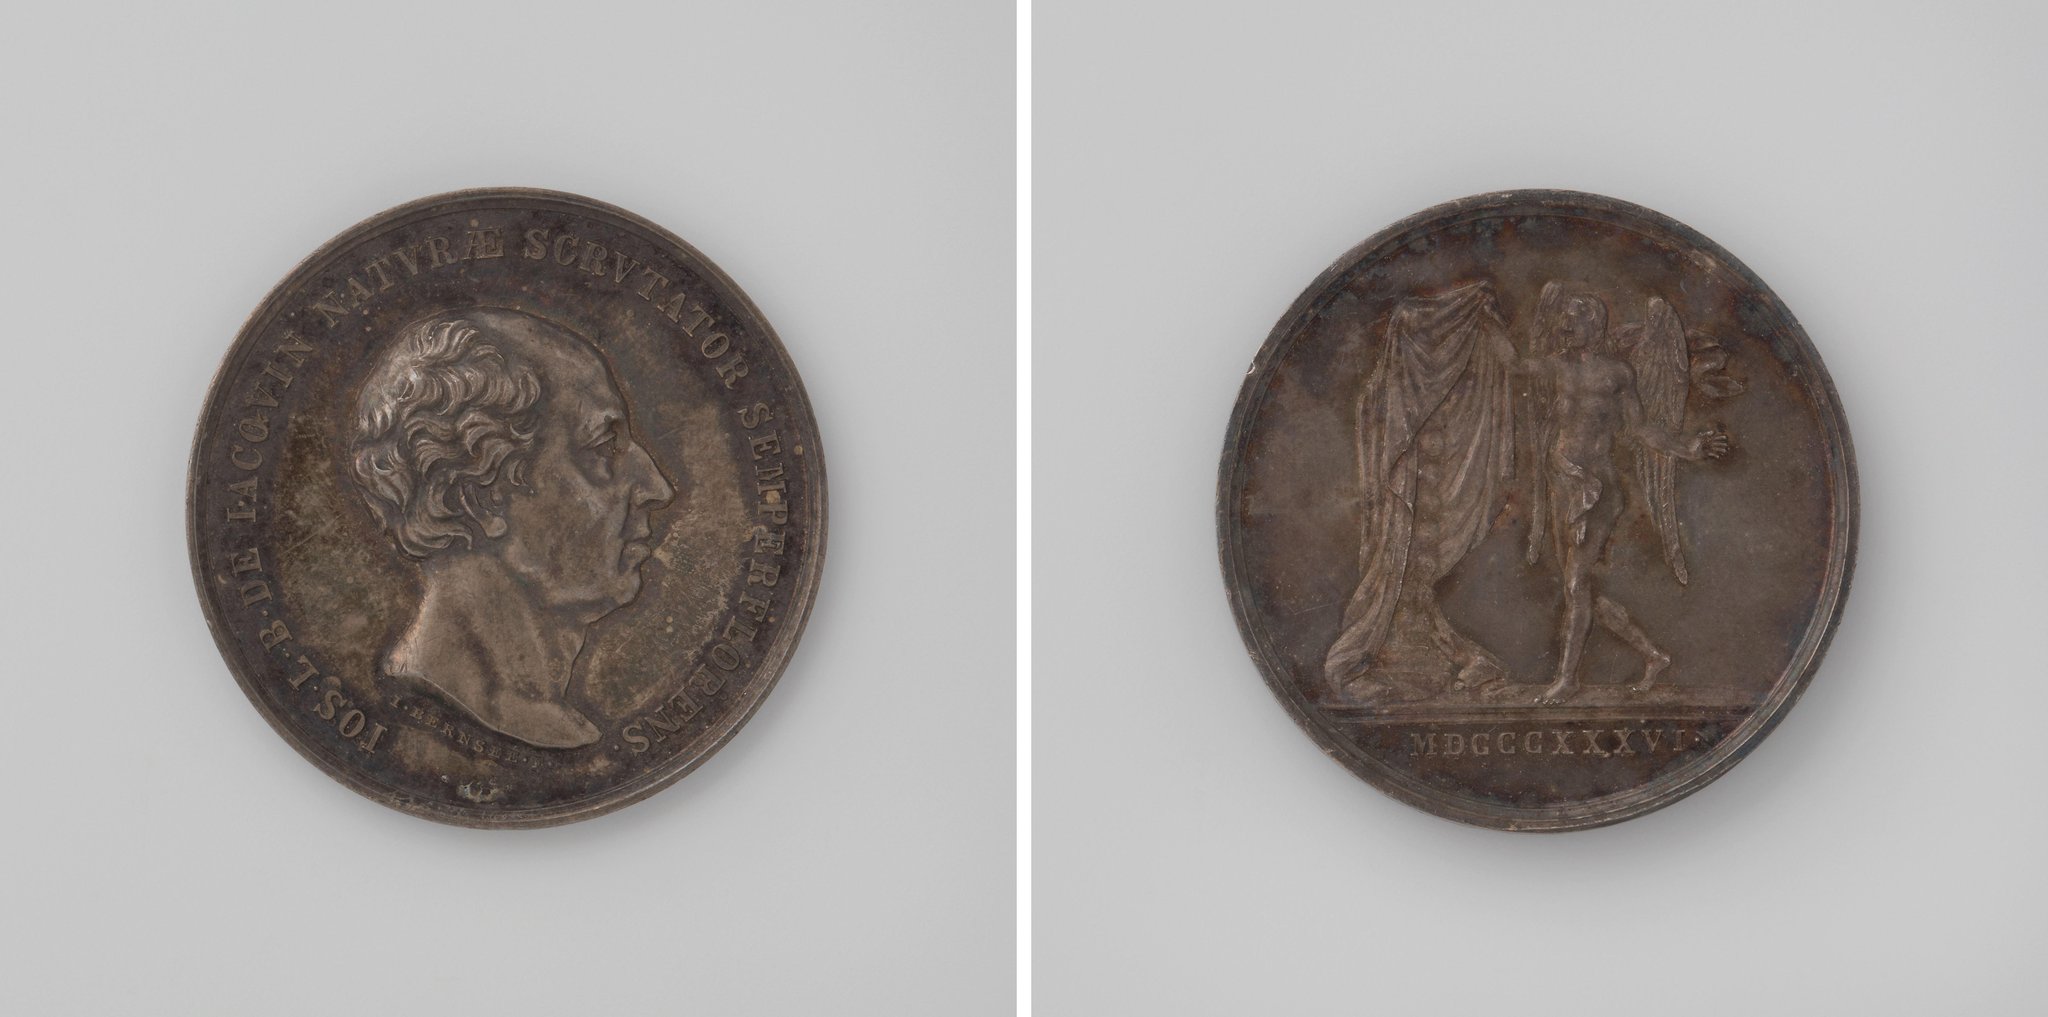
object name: history medal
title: Joseph L.B. de Jacovin, natuuronderzoeker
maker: joseph bernsee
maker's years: 1802-1849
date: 1836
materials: silver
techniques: striking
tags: joseph l.b. de jacovin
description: Zilveren penning. Voorzijde: borststuk man binnen omschrift. Keerzijde: gevleugelde Genius onthuld hoog,staande voorwerp; afsnede: jaartal